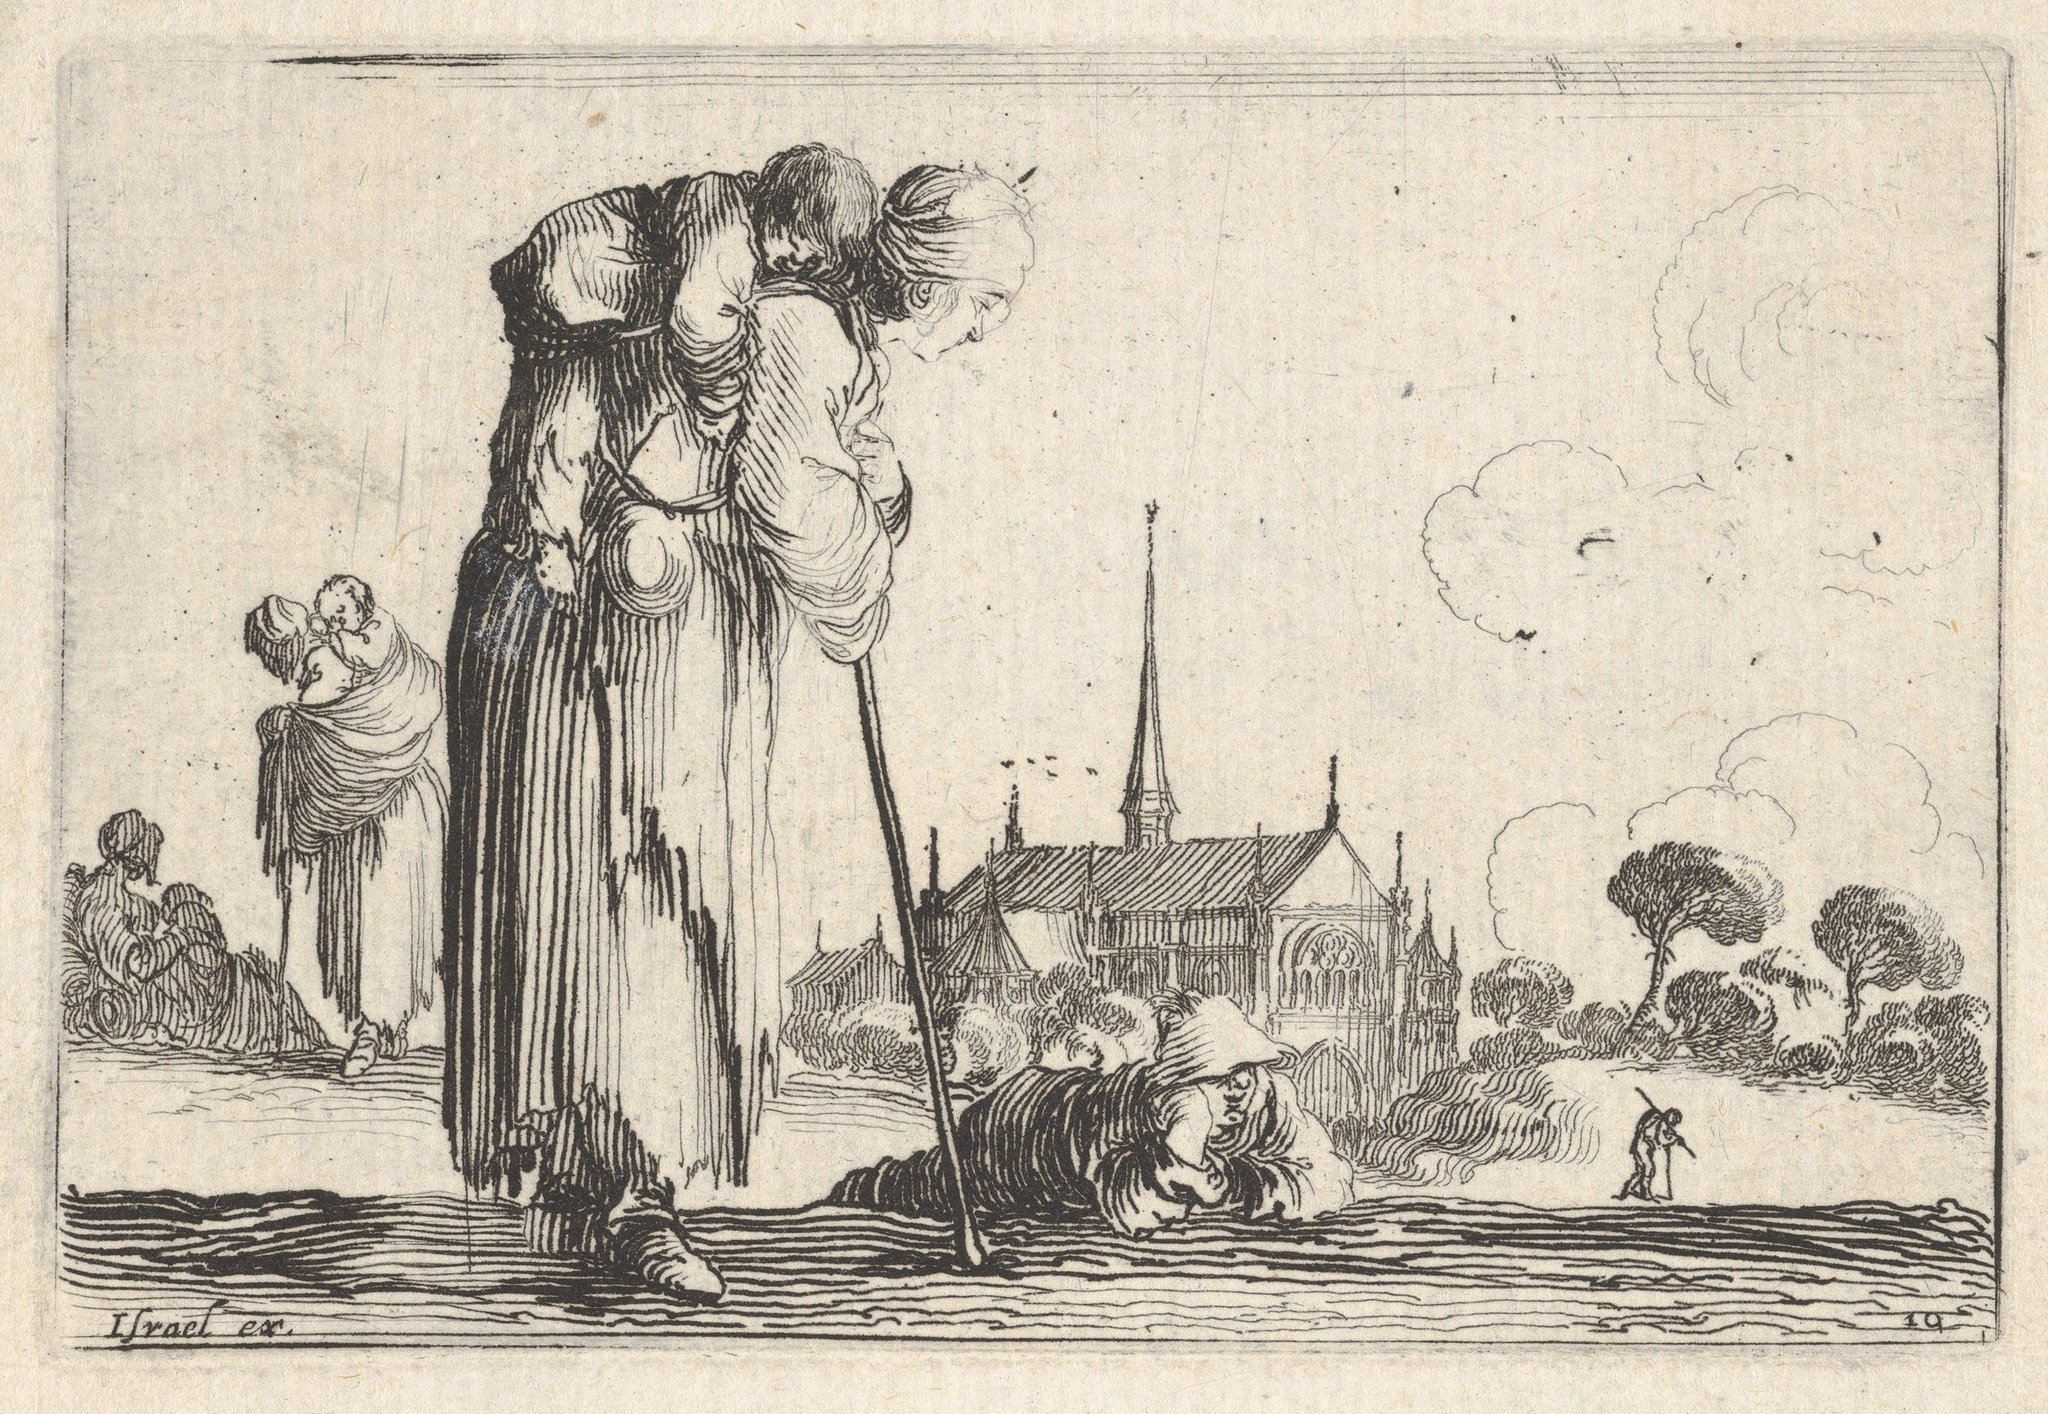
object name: print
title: Plate 10: A peasant woman turned towards the right with a child on her back, a boy lying on the ground behind her in center, two women and a child to left in middleground, a church to right in background, from "Caprice faict par de la Bella"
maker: stefano della bella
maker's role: artist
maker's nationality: italian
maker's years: 1610-1664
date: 1642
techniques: etching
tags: children,women